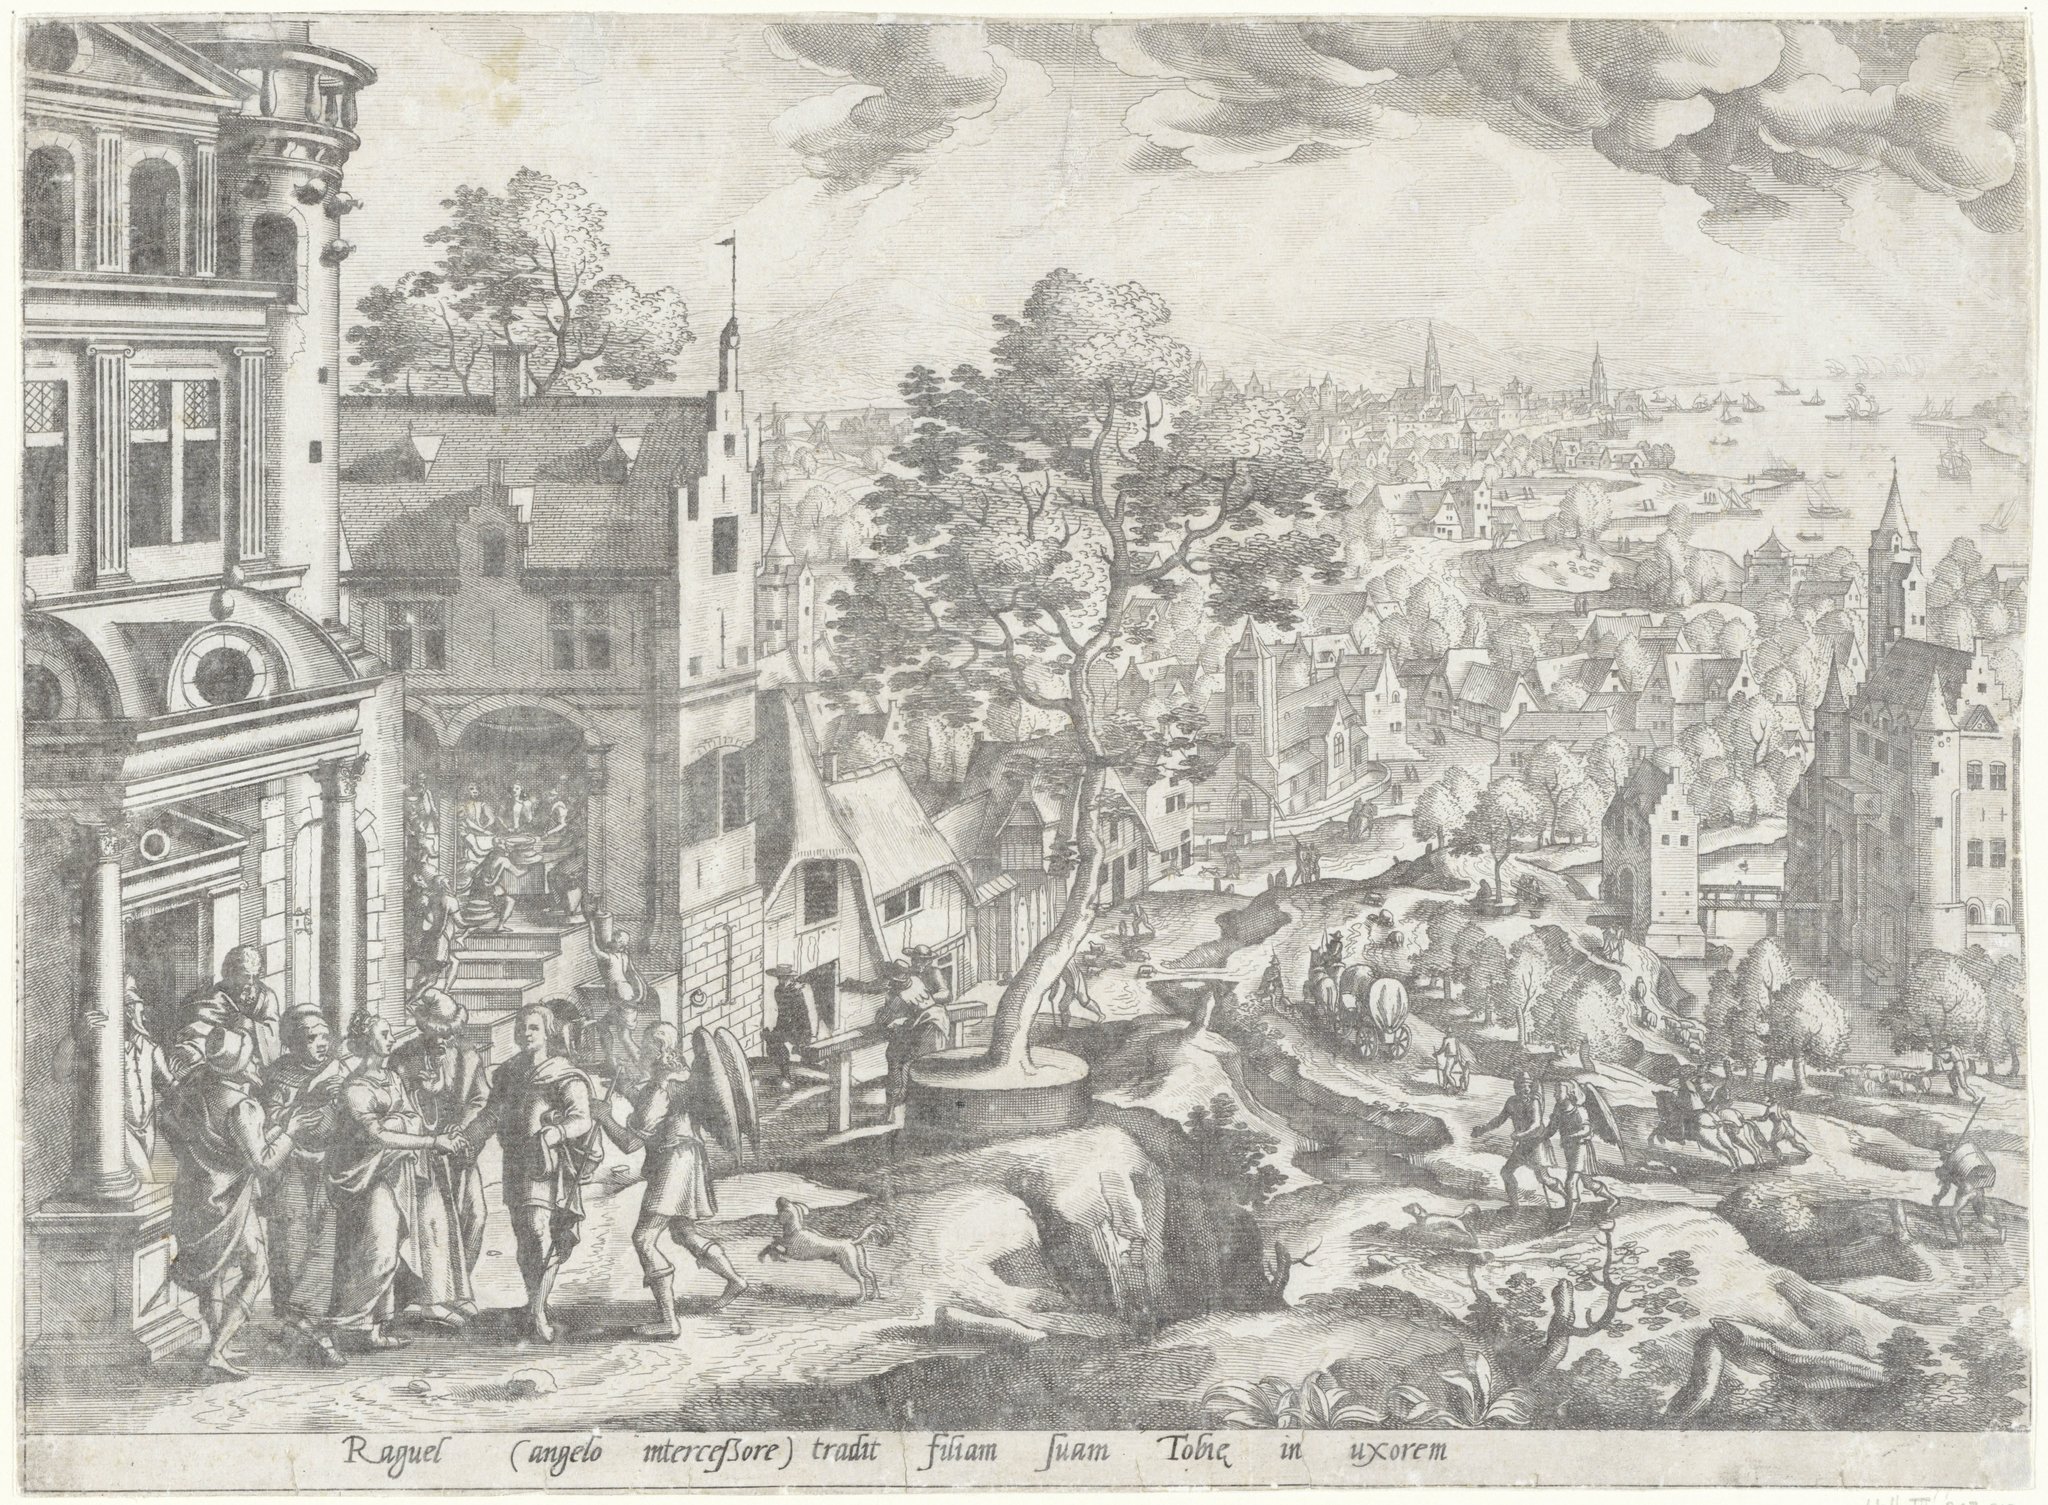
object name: print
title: Huwelijk van Tobias en Sara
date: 1547-1591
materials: paper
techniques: etching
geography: low countries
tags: raguel gives sarah to tobias as his wife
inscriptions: collector's mark: Lugt 2760, collector's mark: Lugt 2228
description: Links geeft Raguel zijn dochter Sara ten huwelijk aan Tobias. Naast Tobias staat de aartsengel Rafaël. Achter hen zitten enkele gasten aan een tafel. Rechts een stadsgezicht met een drukke weg waarop Rafaël, Tobias en zijn hond aan komen lopen. Onderaan in de marge een verklarende, éénregelige tekst in het Latijn.